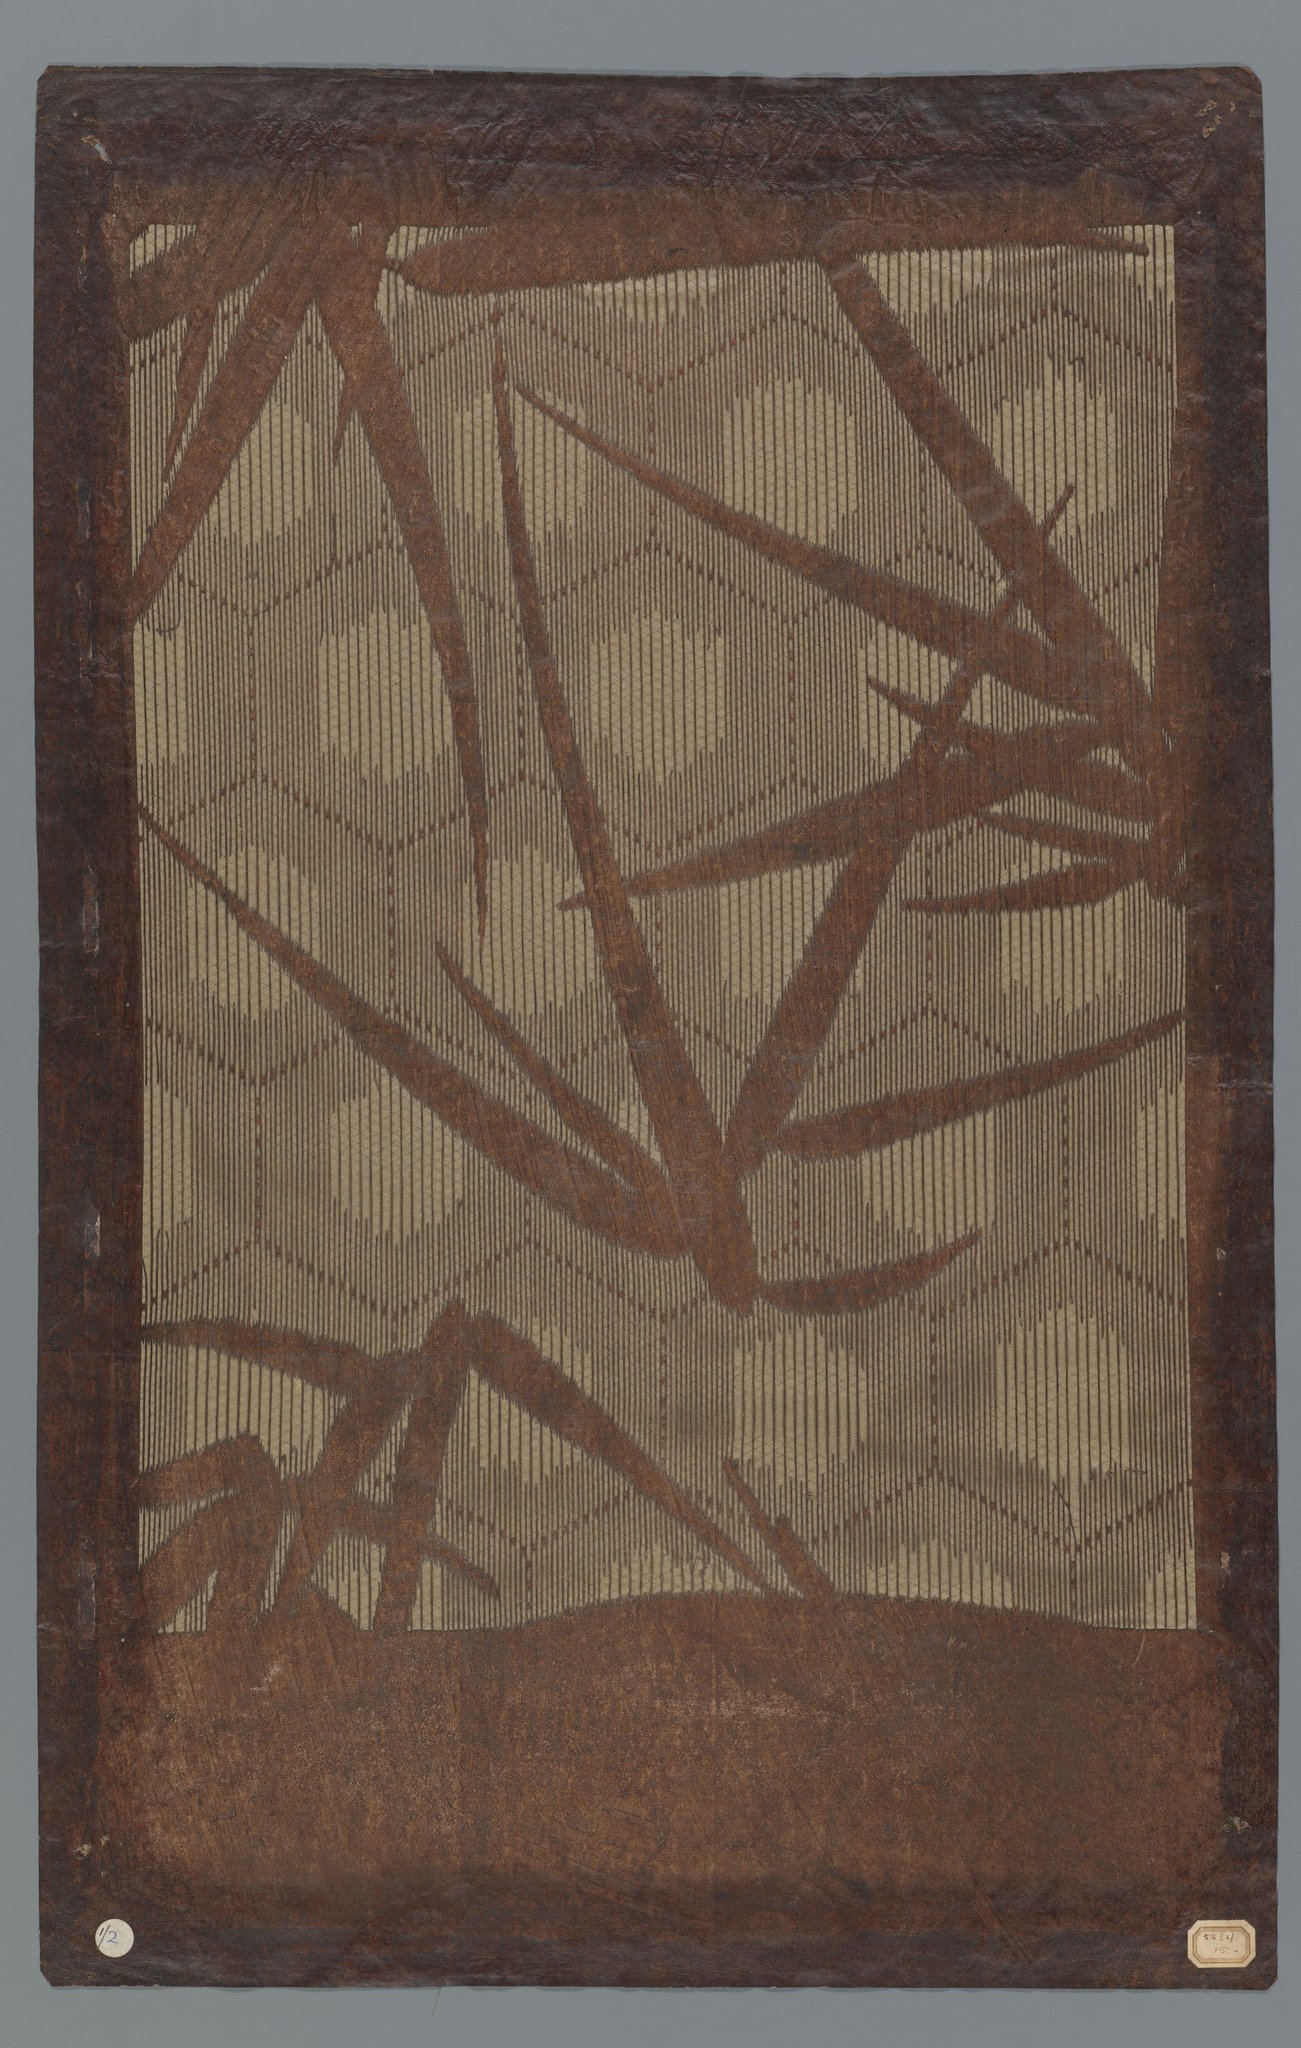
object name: katagami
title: Sjabloon met bamboebladeren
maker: Anonymous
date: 1800-1909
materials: paper, silk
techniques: cutting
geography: japan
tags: foliage ~ ornament, plants and herbs: bamboo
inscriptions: label: ‘1/2’, label: ‘472/66’, label: ‘5534 / 15.’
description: Japanse sjabloon (katagami) met een patroon van bamboebladeren tegen een fond van zeshoeken of honingraat.